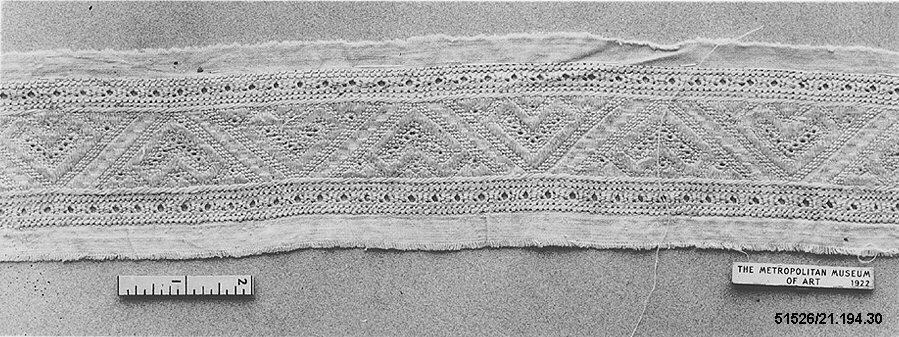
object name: band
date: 1767-1833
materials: linen, silk